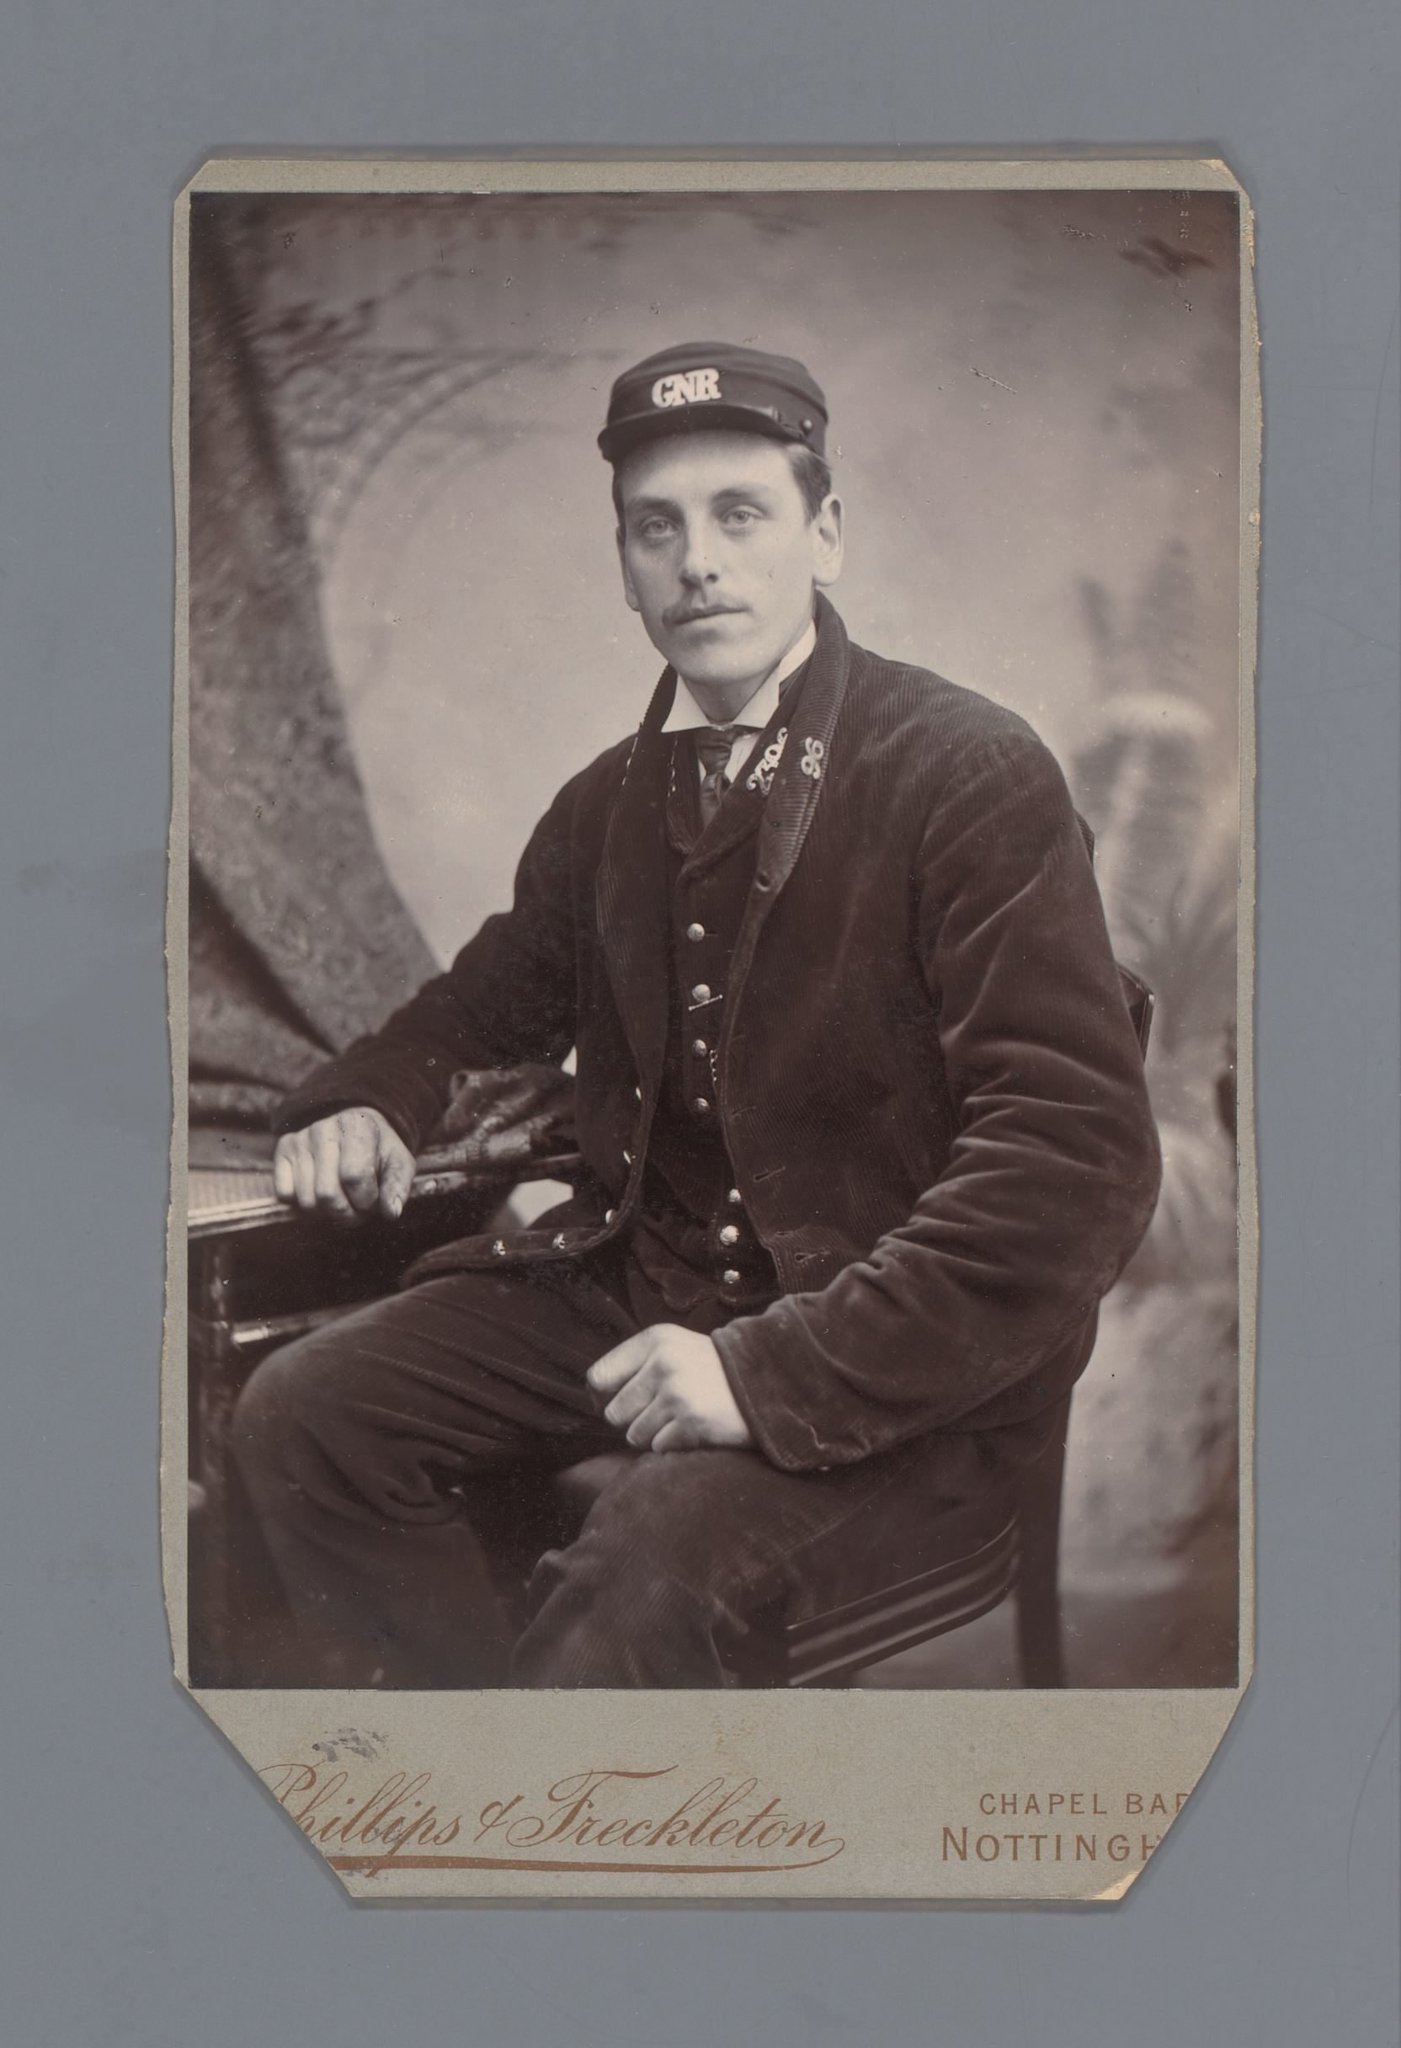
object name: cabinet photograph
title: Portret van een man in het uniform van de Great Northern Railway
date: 1880-1900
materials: cardboard, photographic support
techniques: gelatin silver print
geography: nottingham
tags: railway-traffic, adult man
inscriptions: name: ‘Phillips & Freckleton Chapel Ba[...] Nottingh[...]’, inscription: ‘Phillips & Freckleton photographers Chapel Bar Nottingham’